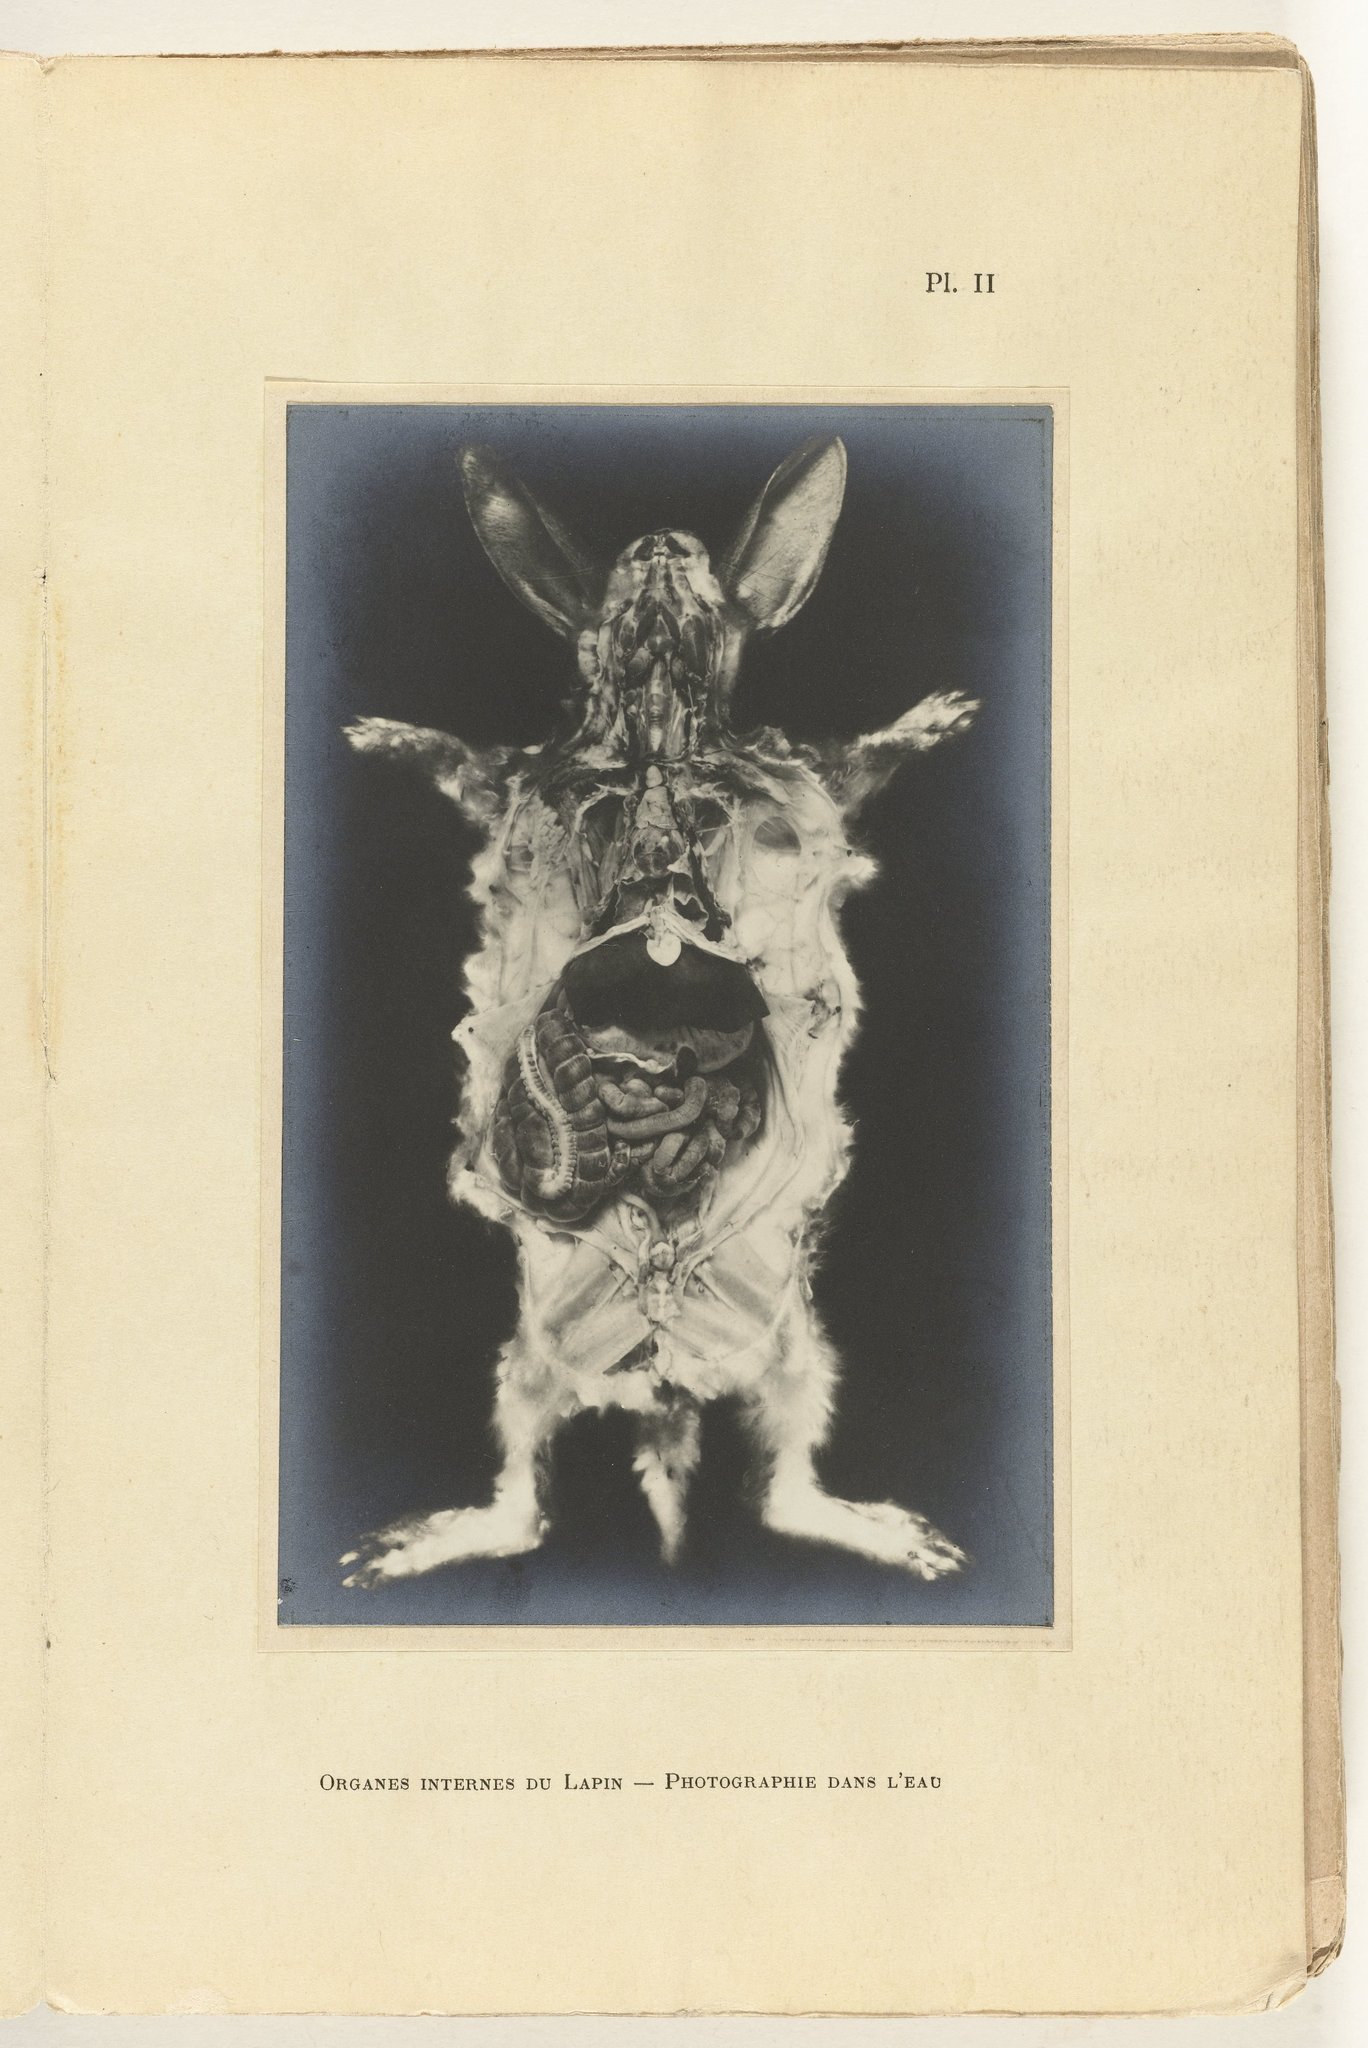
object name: page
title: Organes internes du lapin -Photographie dans l'eau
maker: adolphe louis donnadieu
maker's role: wetenschapper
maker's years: 1840-1911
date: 1891-1901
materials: photographic support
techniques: gelatin silver print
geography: paris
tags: parts of the human body (skeleton excepted), rodents: rabbit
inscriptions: number: ‘Pl. II’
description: Foto in album 'La photographie des objets immergés', 1901.